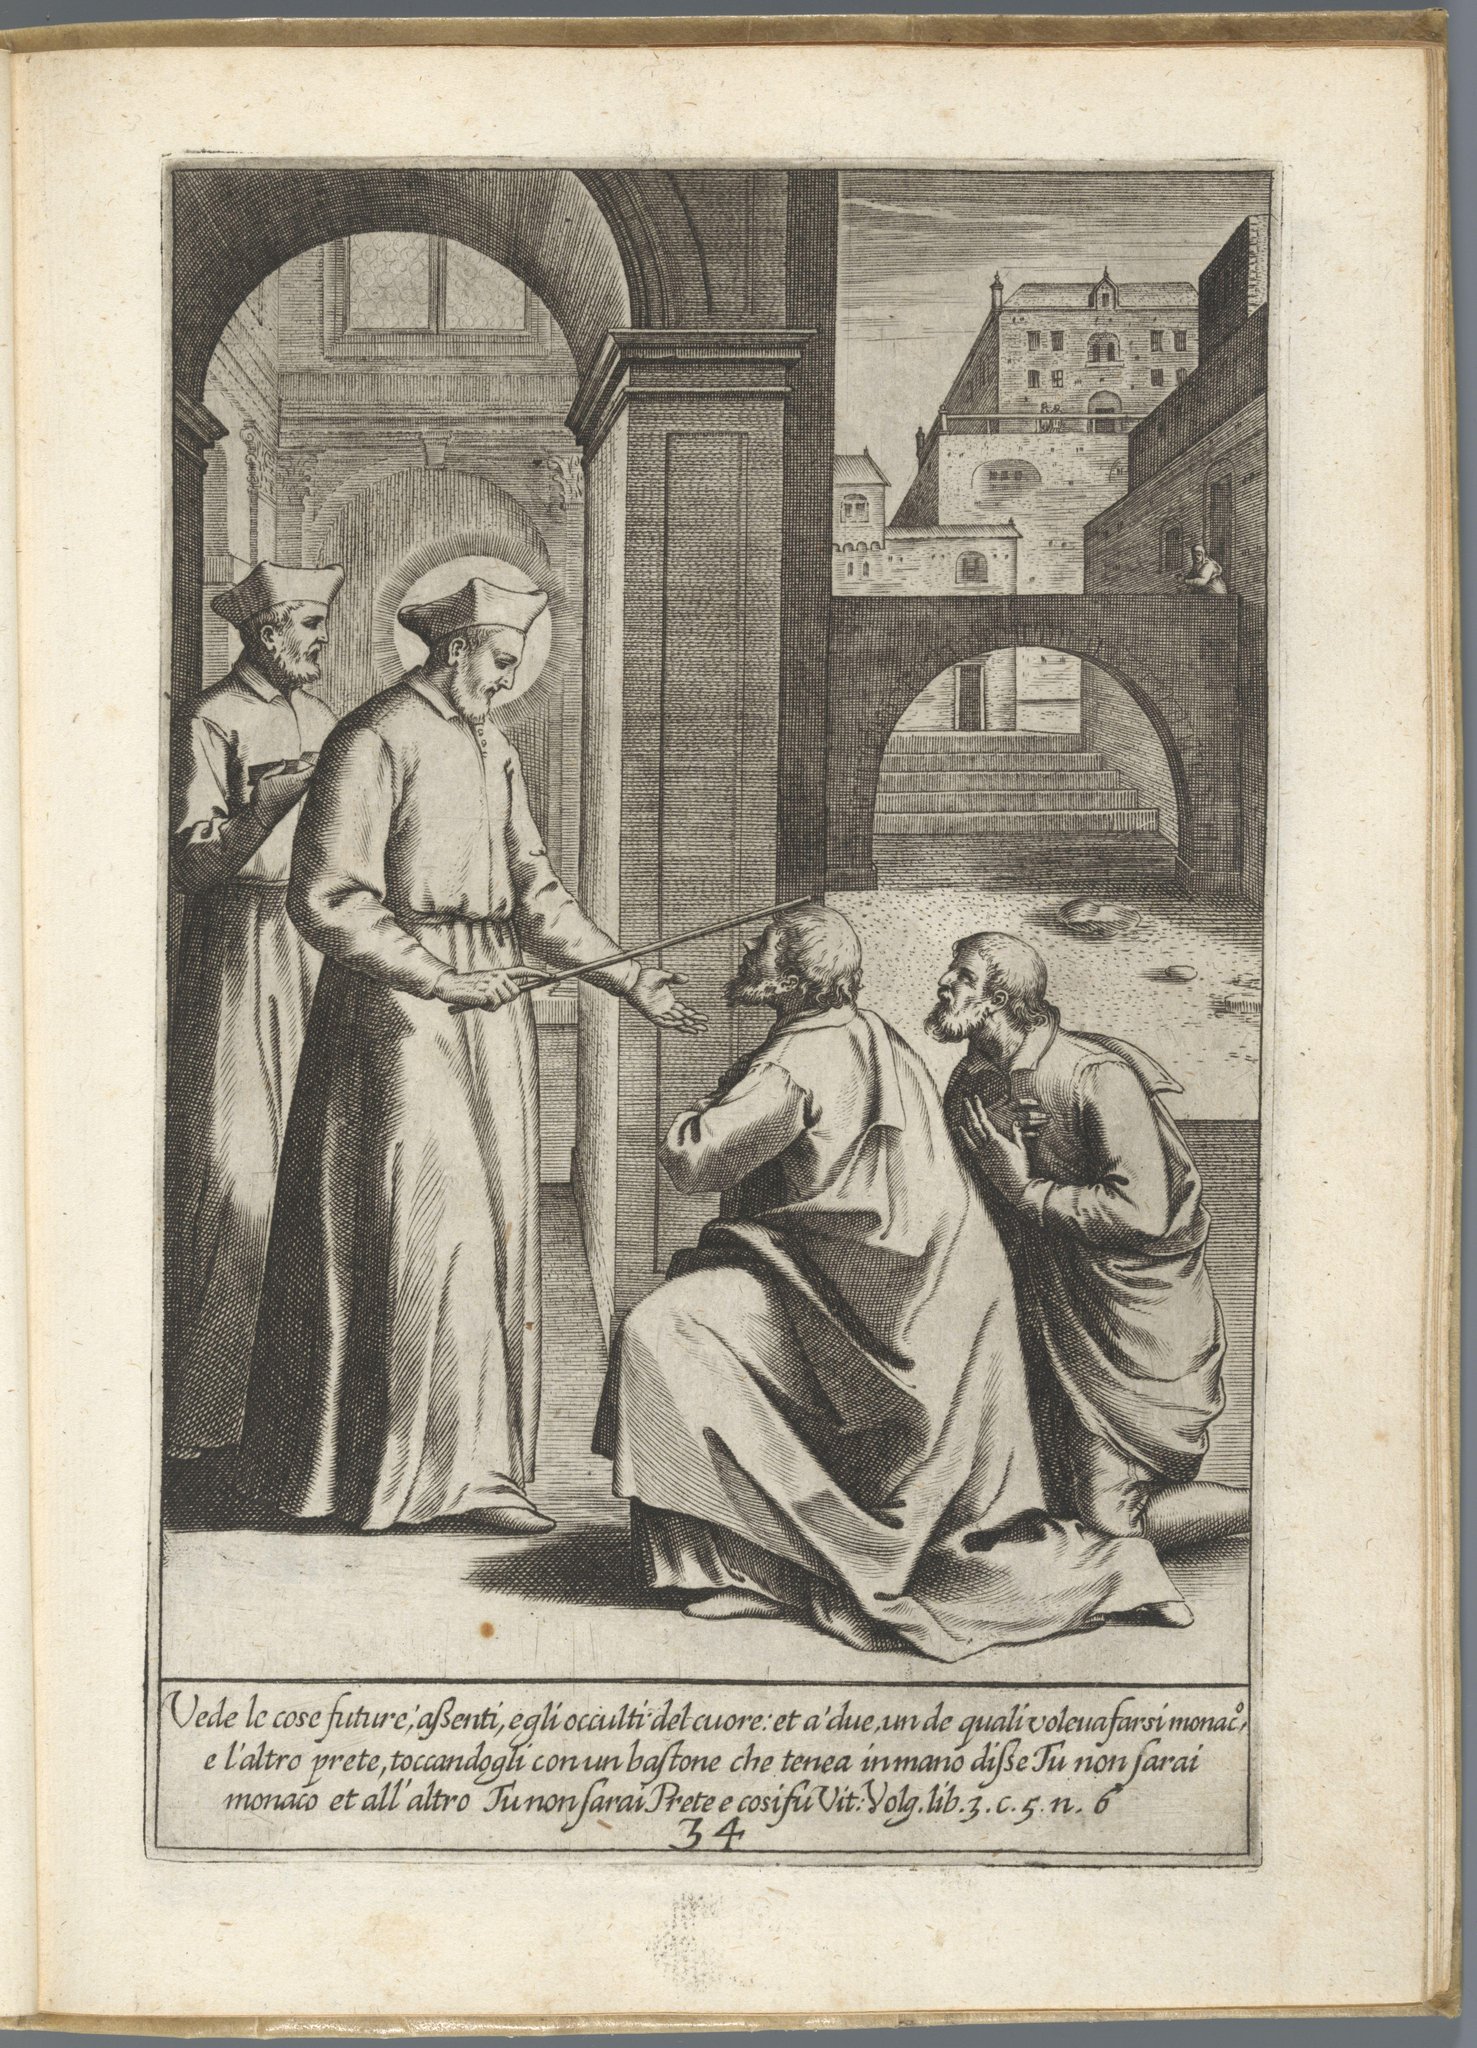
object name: print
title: Filippo Neri ziet de toekomst van twee mannen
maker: luca ciamberlano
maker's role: painter, print maker, publisher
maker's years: 1570-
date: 1630-1641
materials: paper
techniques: engraving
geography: rome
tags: clergyman, the founder of the congregation of the oratory (oratorians) philip neri; possible attributes: lily, rosary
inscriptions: collector's mark: Lugt 2228, collector's mark: Lugt 2760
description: Filippo Neri ziet de toekomst van twee mannen die monnik en priester wilden worden. Prent nr. 34 in een serie van 44 prenten met scènes uit het leven van de heilige Filippo Neri.